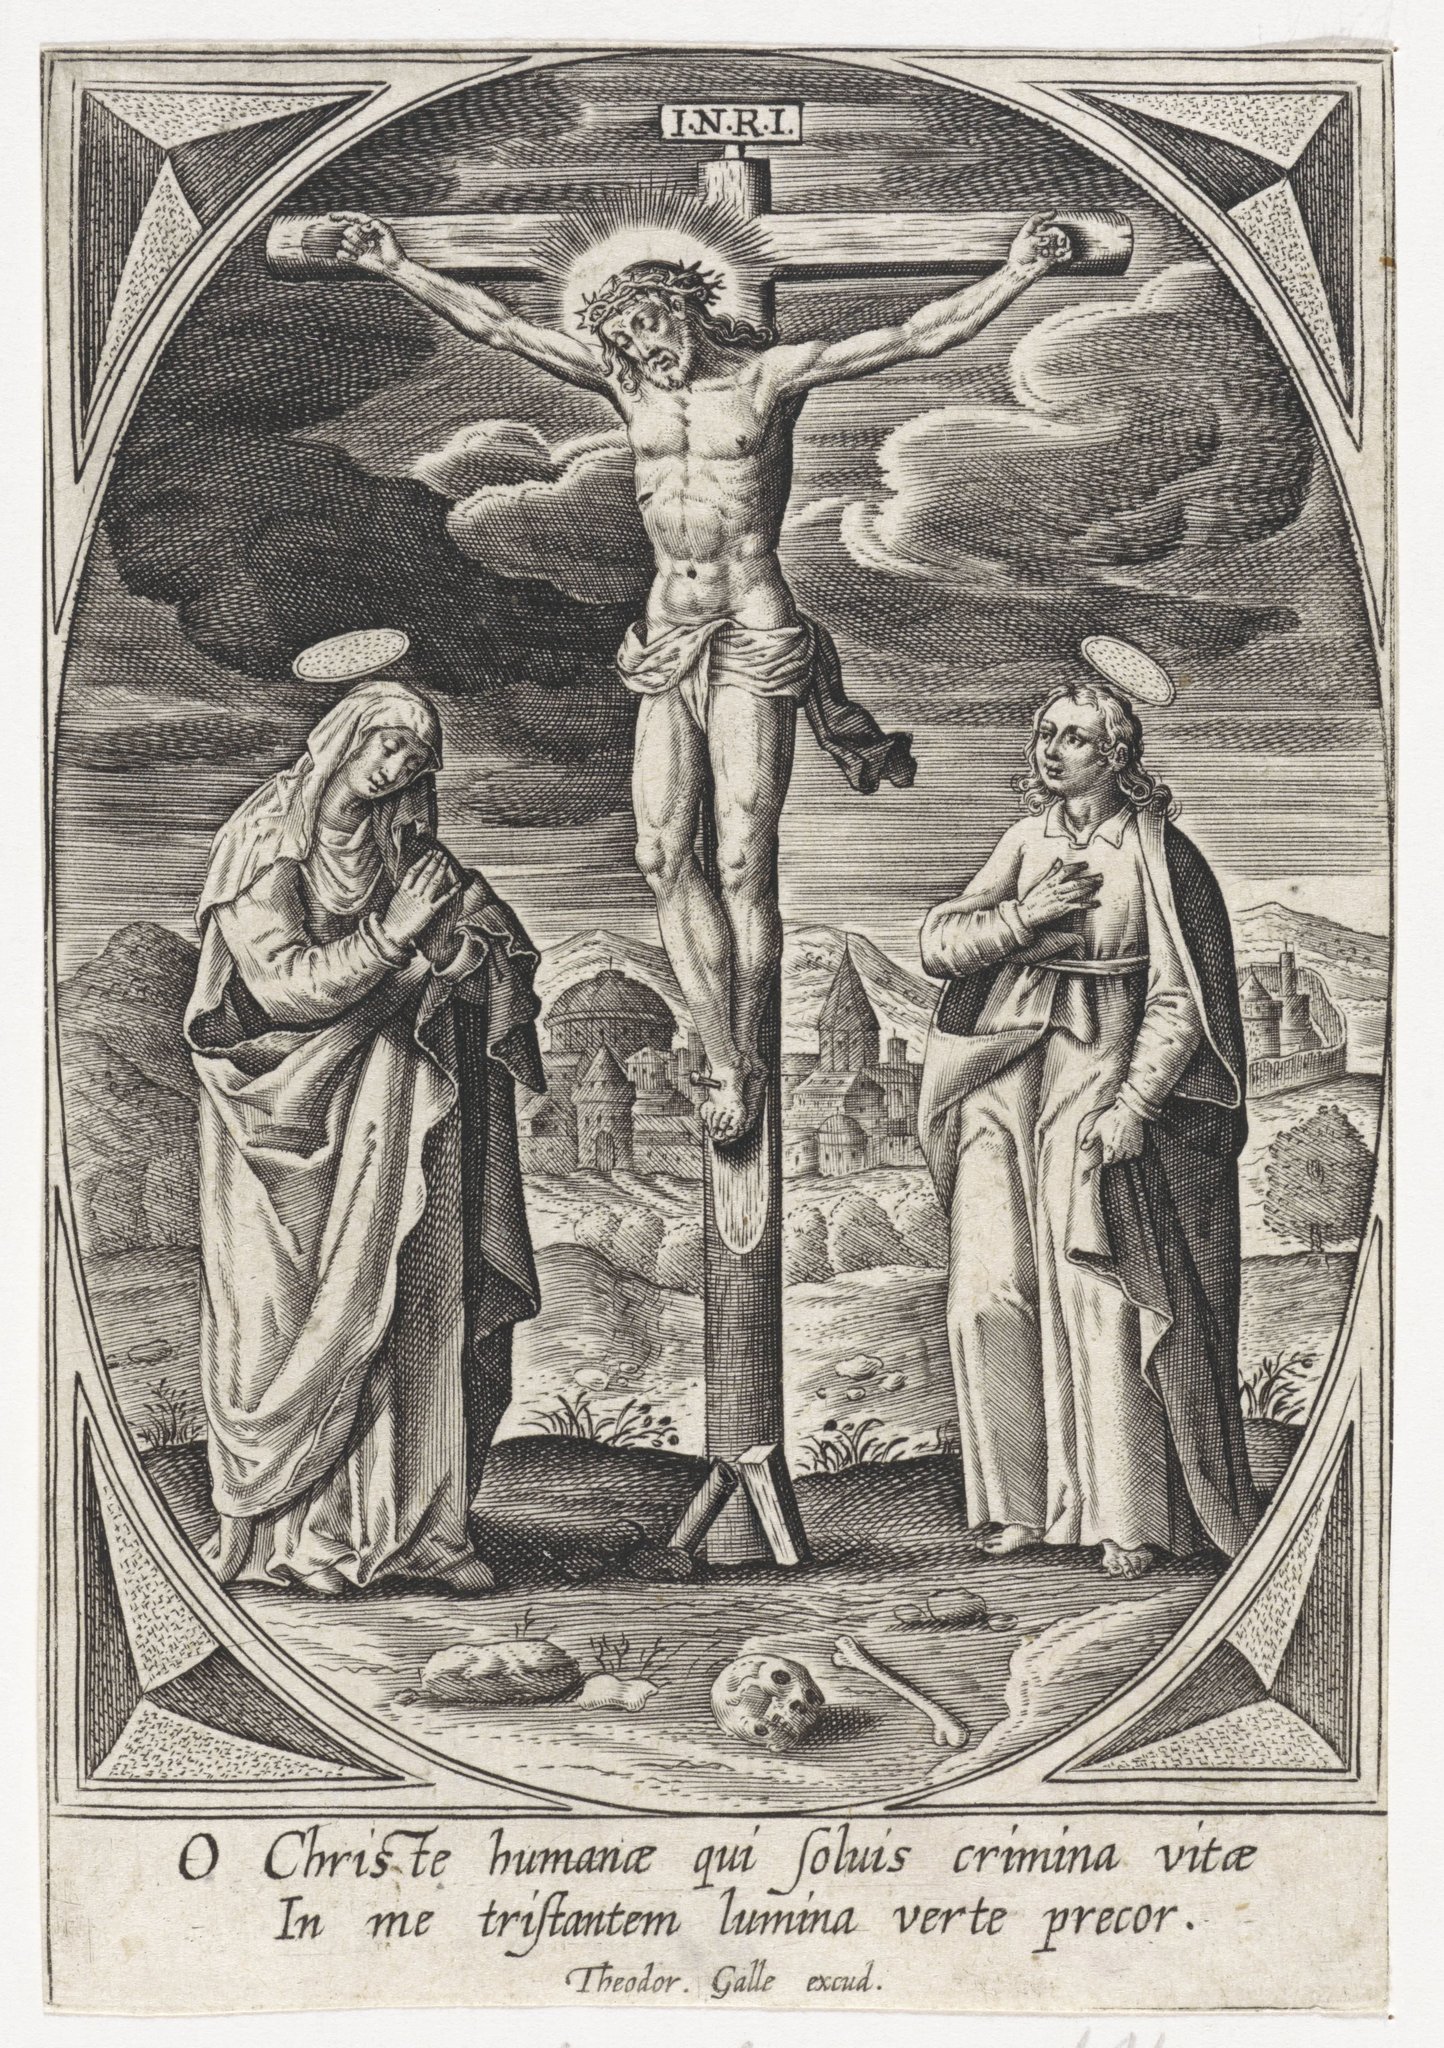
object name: print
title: Christus aan het kruis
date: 1595-1633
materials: paper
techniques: engraving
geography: antwerp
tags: crucified christ with mary and john on either side of the cross; holy rood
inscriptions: number: ‘38. - 22, a’, collector's mark: Lugt 240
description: Kruisdood van Christus op Golgota. Maria en Johannes de Doper staan onder het kruis. Op de achtergrond een gezicht op Jeruzalem. In de marge een tweeregelig onderschrift in het Latijn.